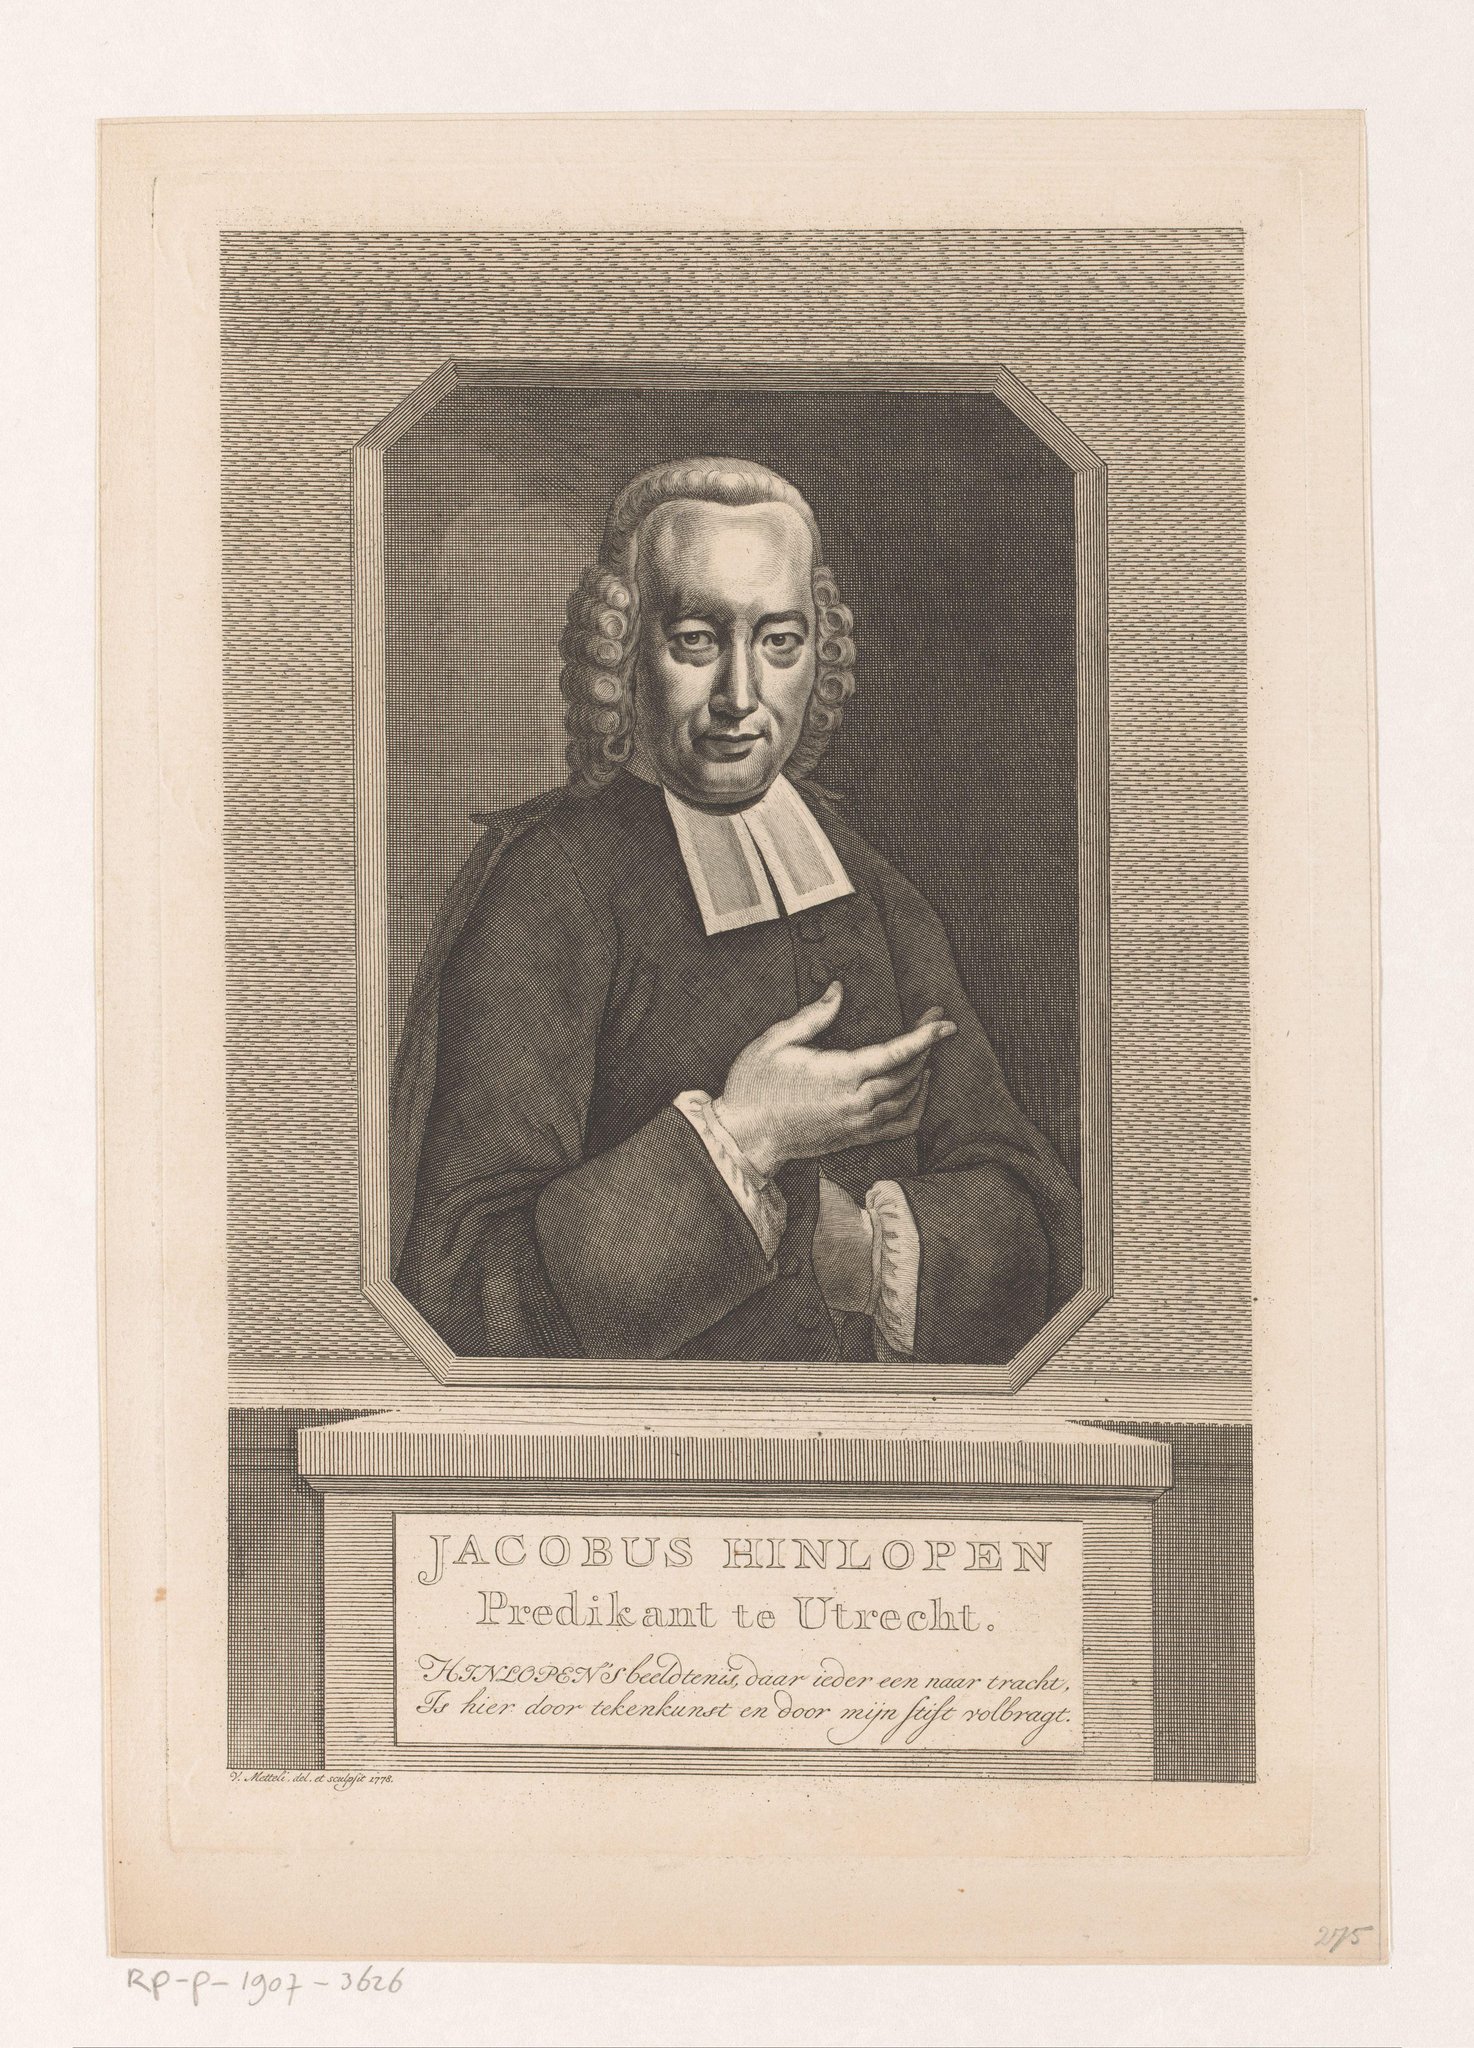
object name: print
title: Portret van Jacobus Hinlopen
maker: nicolaus mettel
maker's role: print maker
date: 1778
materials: paper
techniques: engraving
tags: utrecht, historical persons, wig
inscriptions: collector's mark: Lugt 2228